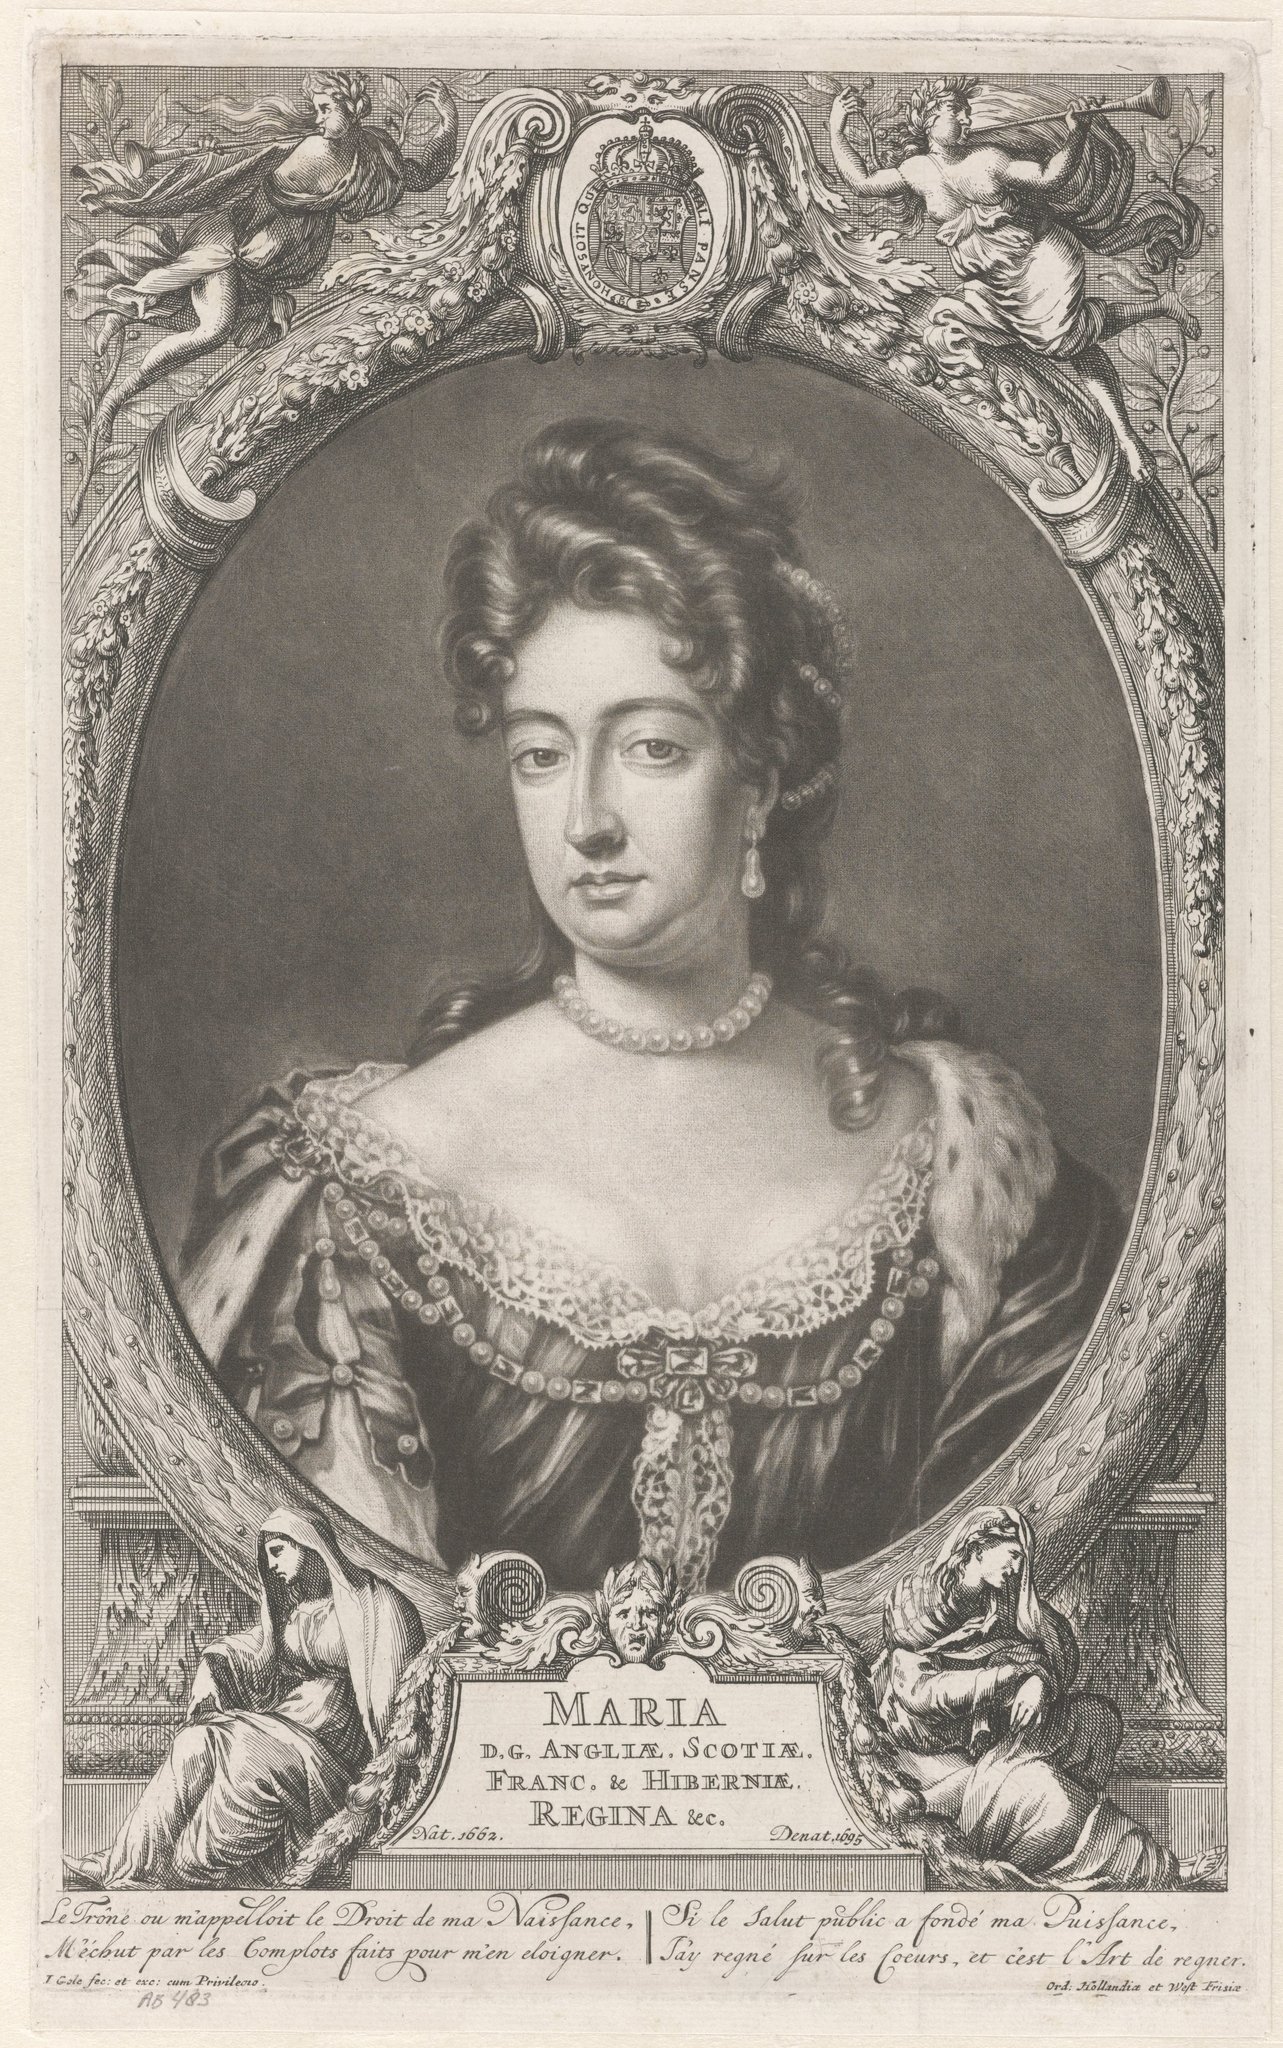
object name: print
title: Portret van Maria II Stuart, koningin van Engeland en Schotland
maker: jacob gole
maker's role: print maker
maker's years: 1660-1724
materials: paper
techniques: etching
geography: amsterdam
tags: london, maria ii stuart (koningin van engeland, schotland en ierland), trees: olive-tree (+ sprig, twig)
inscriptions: stamp: ‘FOTO’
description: Buste van Maria Stuart in ovaal. Boven het ovaal het wapen van Willem III tussen twee vrouwenfiguren met bazuinen. Onder het ovaal de naam van de voorgestelde met haar jaartallen tussen twee treurende vrouwenfiguren. Onder de afbeelding een vierregelig Frans gedicht.